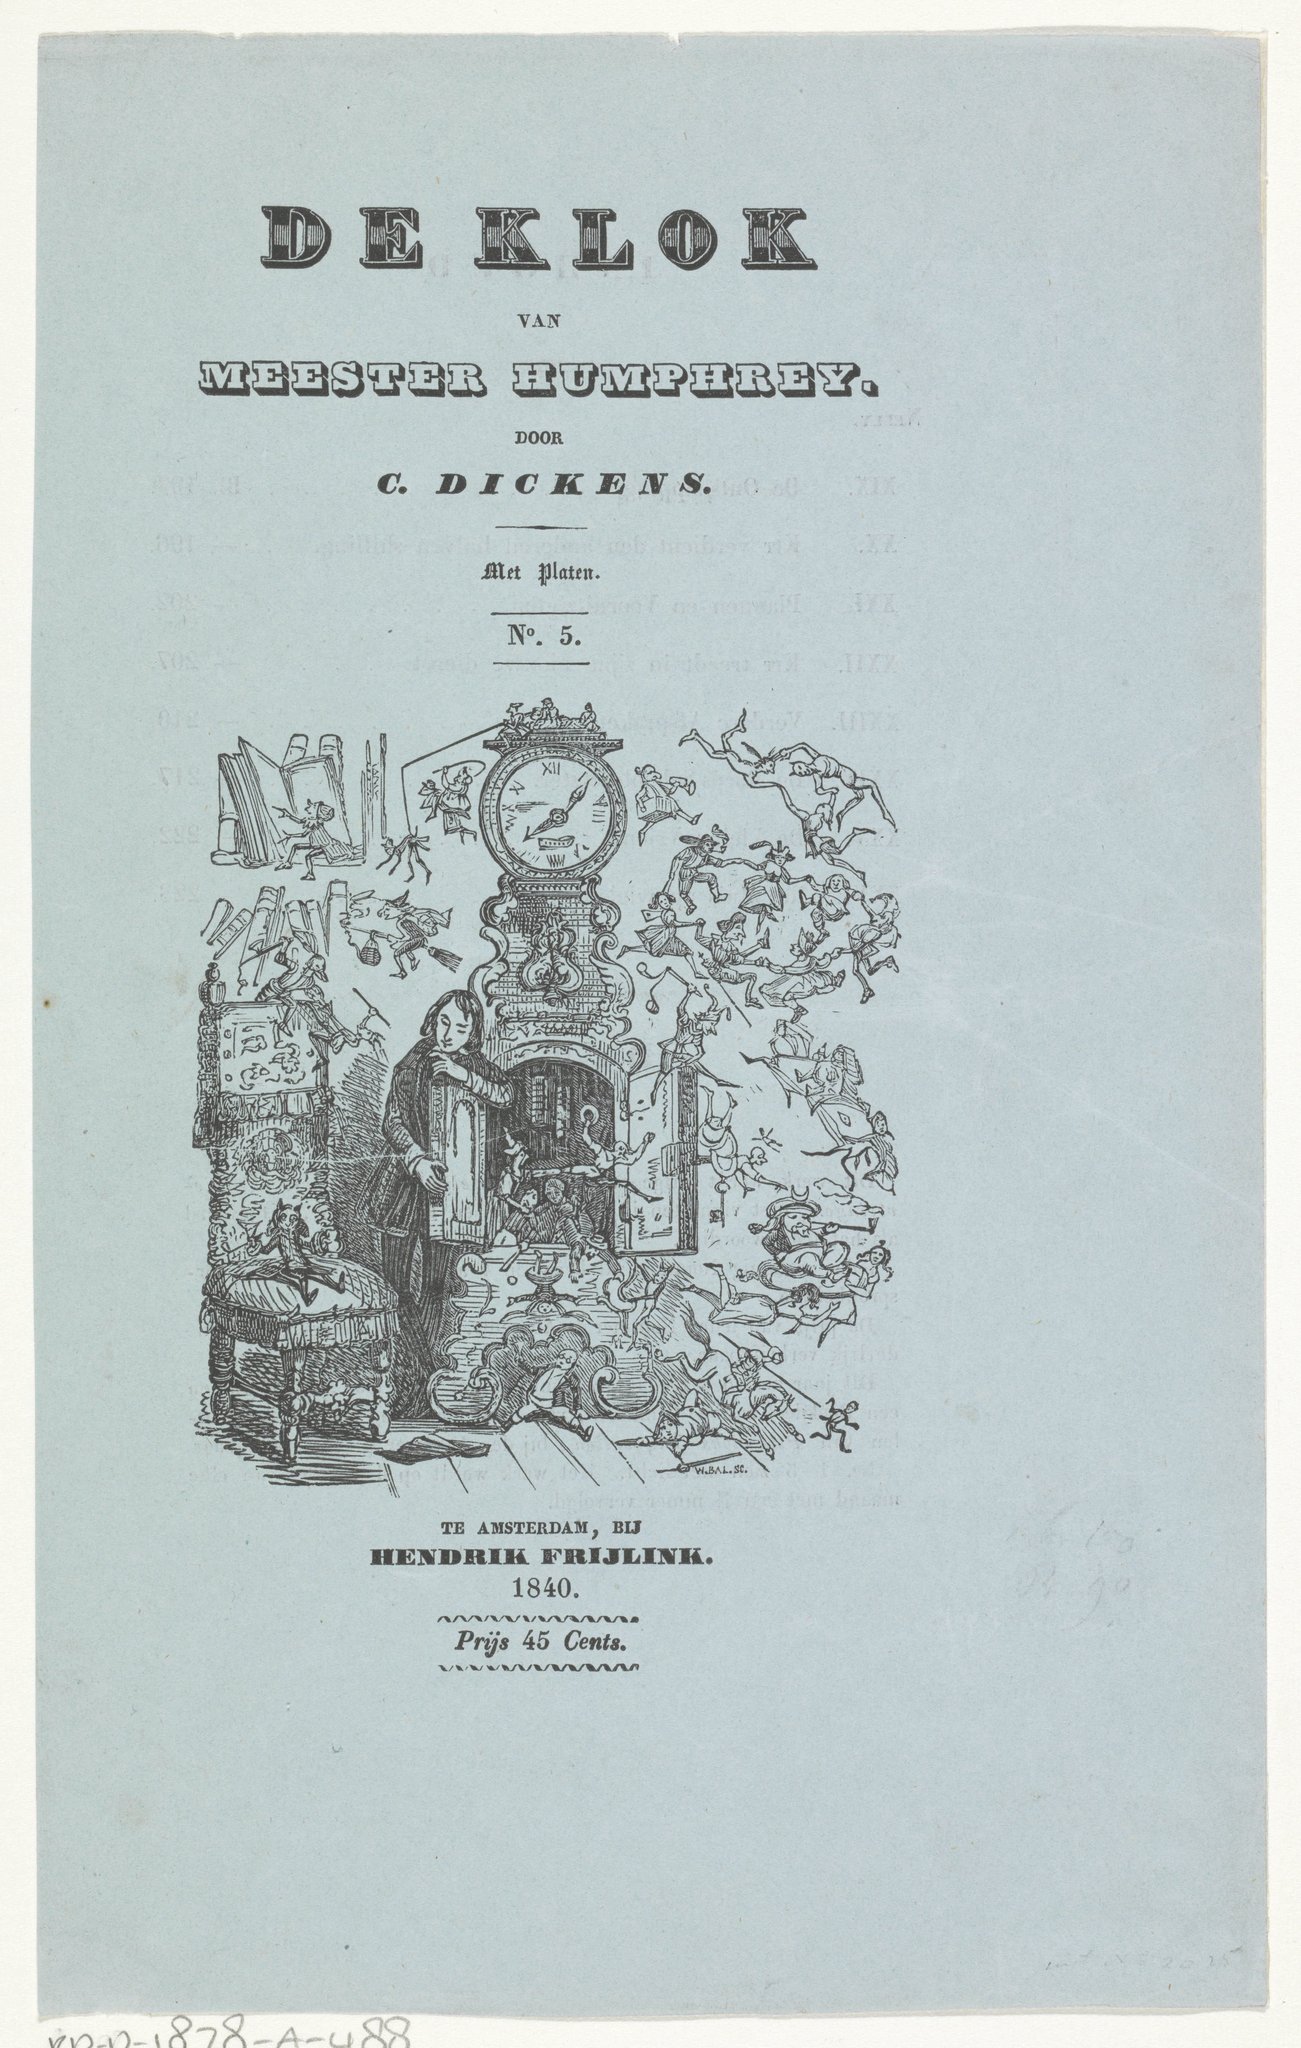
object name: print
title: Titelpagina voor: Charles Dickens, De klok van meester Humphrey, 1840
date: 1840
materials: paper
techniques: letterpress printing, engraving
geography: amsterdam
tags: clock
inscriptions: collector's mark: Lugt 2228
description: Titelpagina voor: Dickens, Charles. De klok van meester Humphrey. Amsterdam: Hendrik Frijlink, 1840.